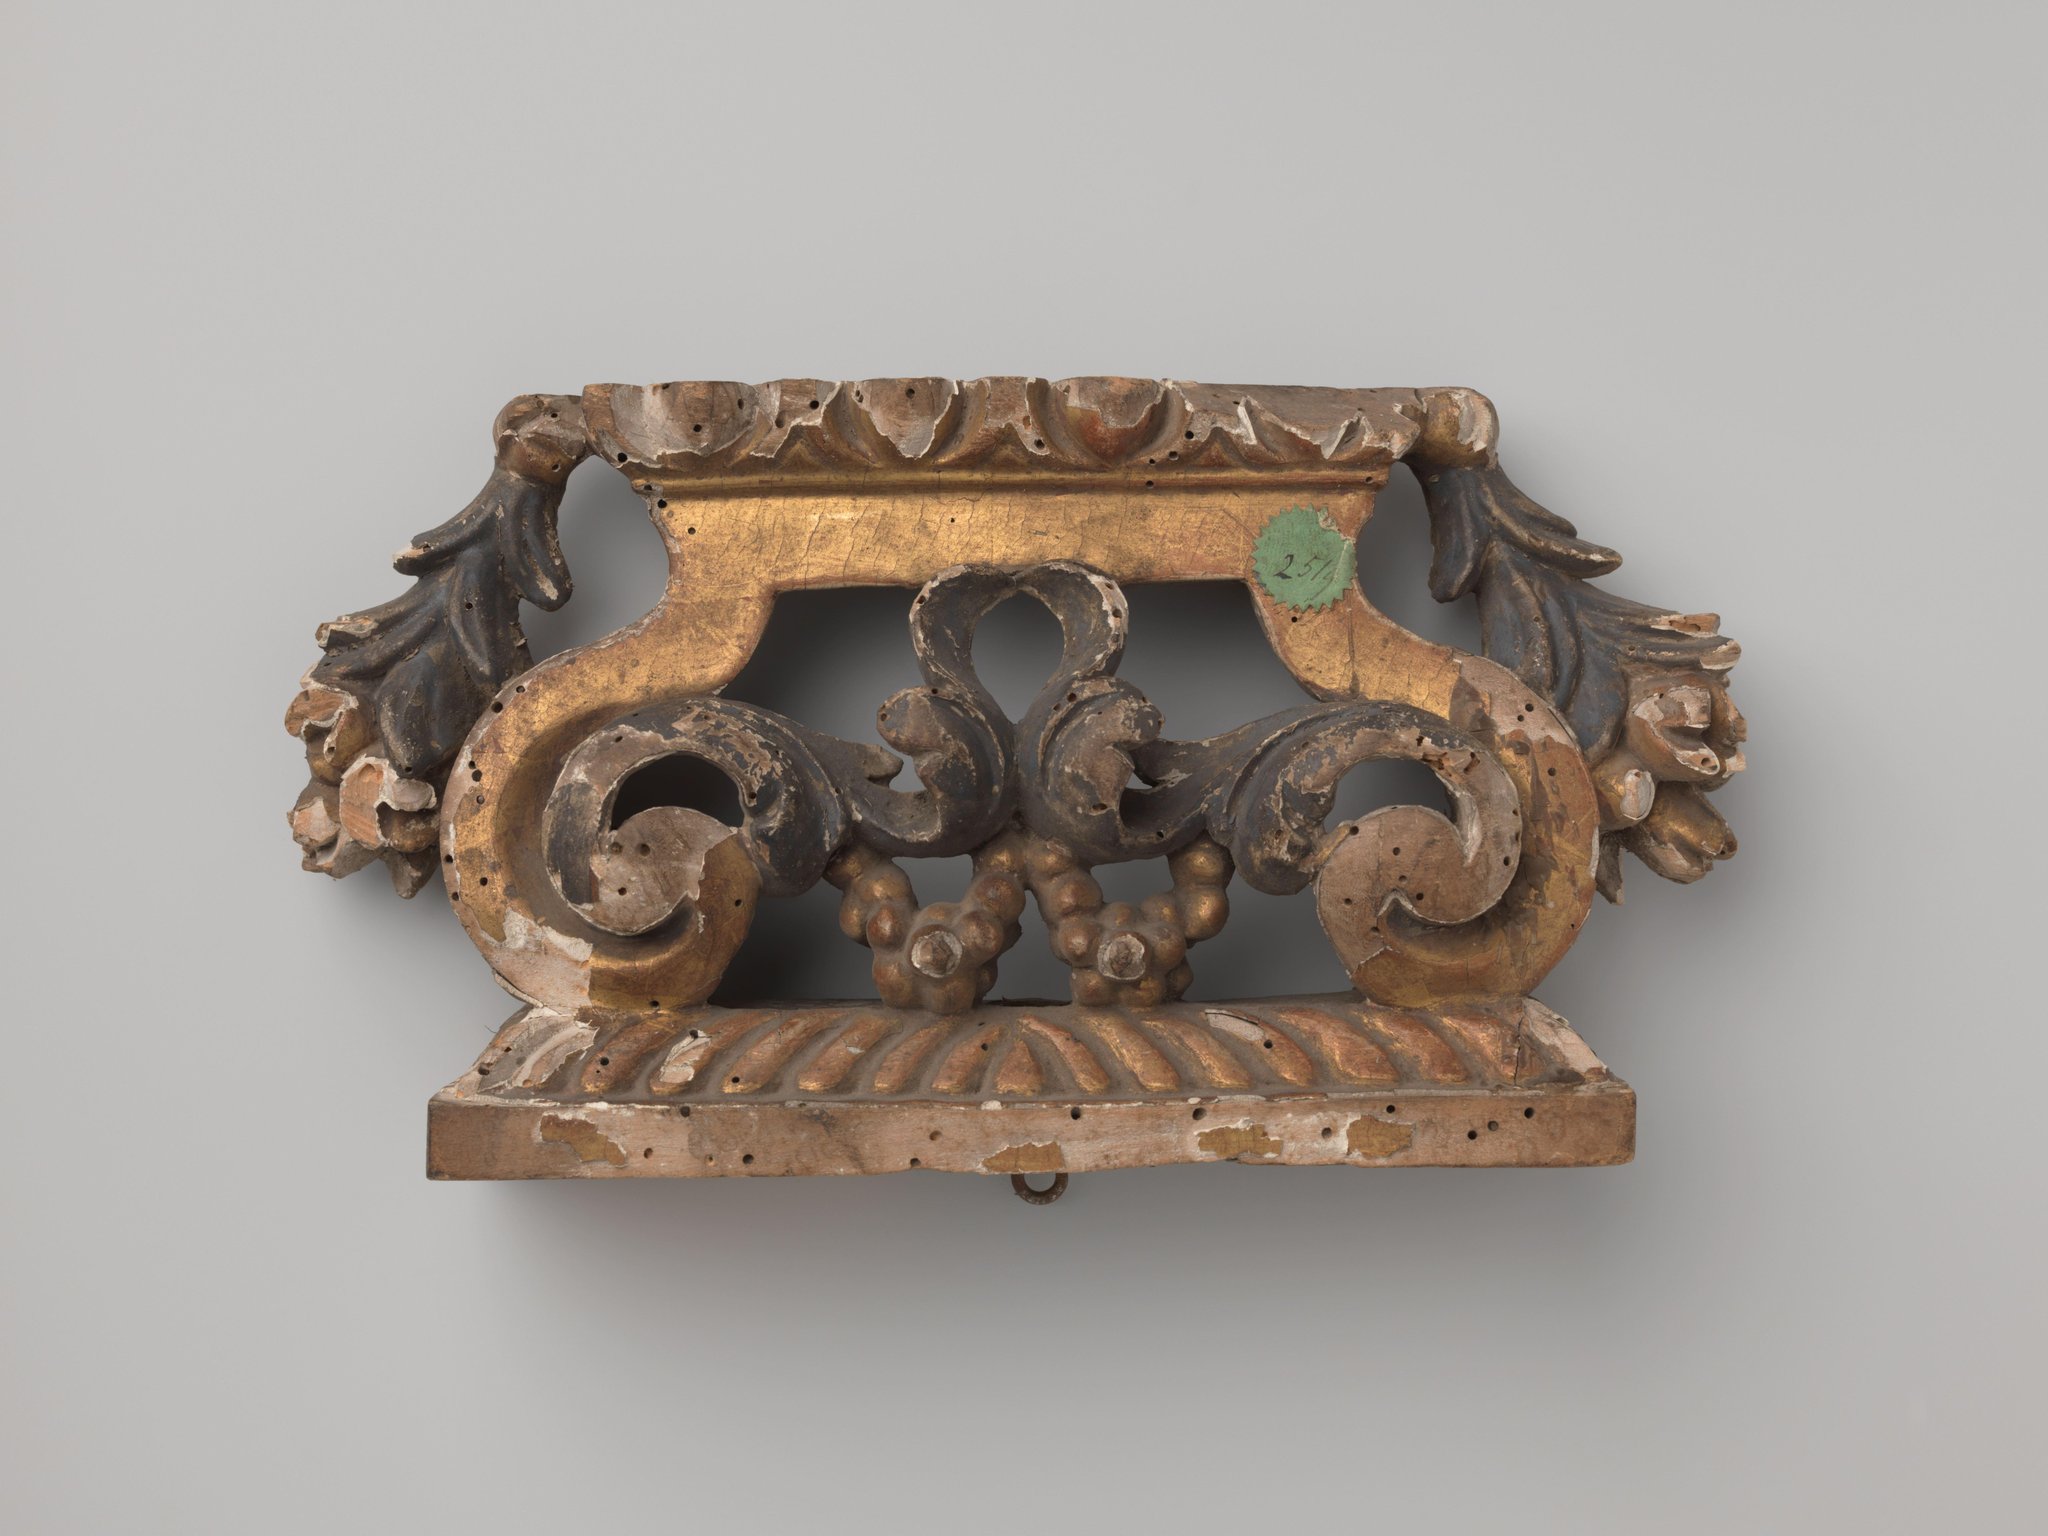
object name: base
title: Voetstuk van hout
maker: Anonymous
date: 1400-1950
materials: wood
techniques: cutting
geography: northern netherlands